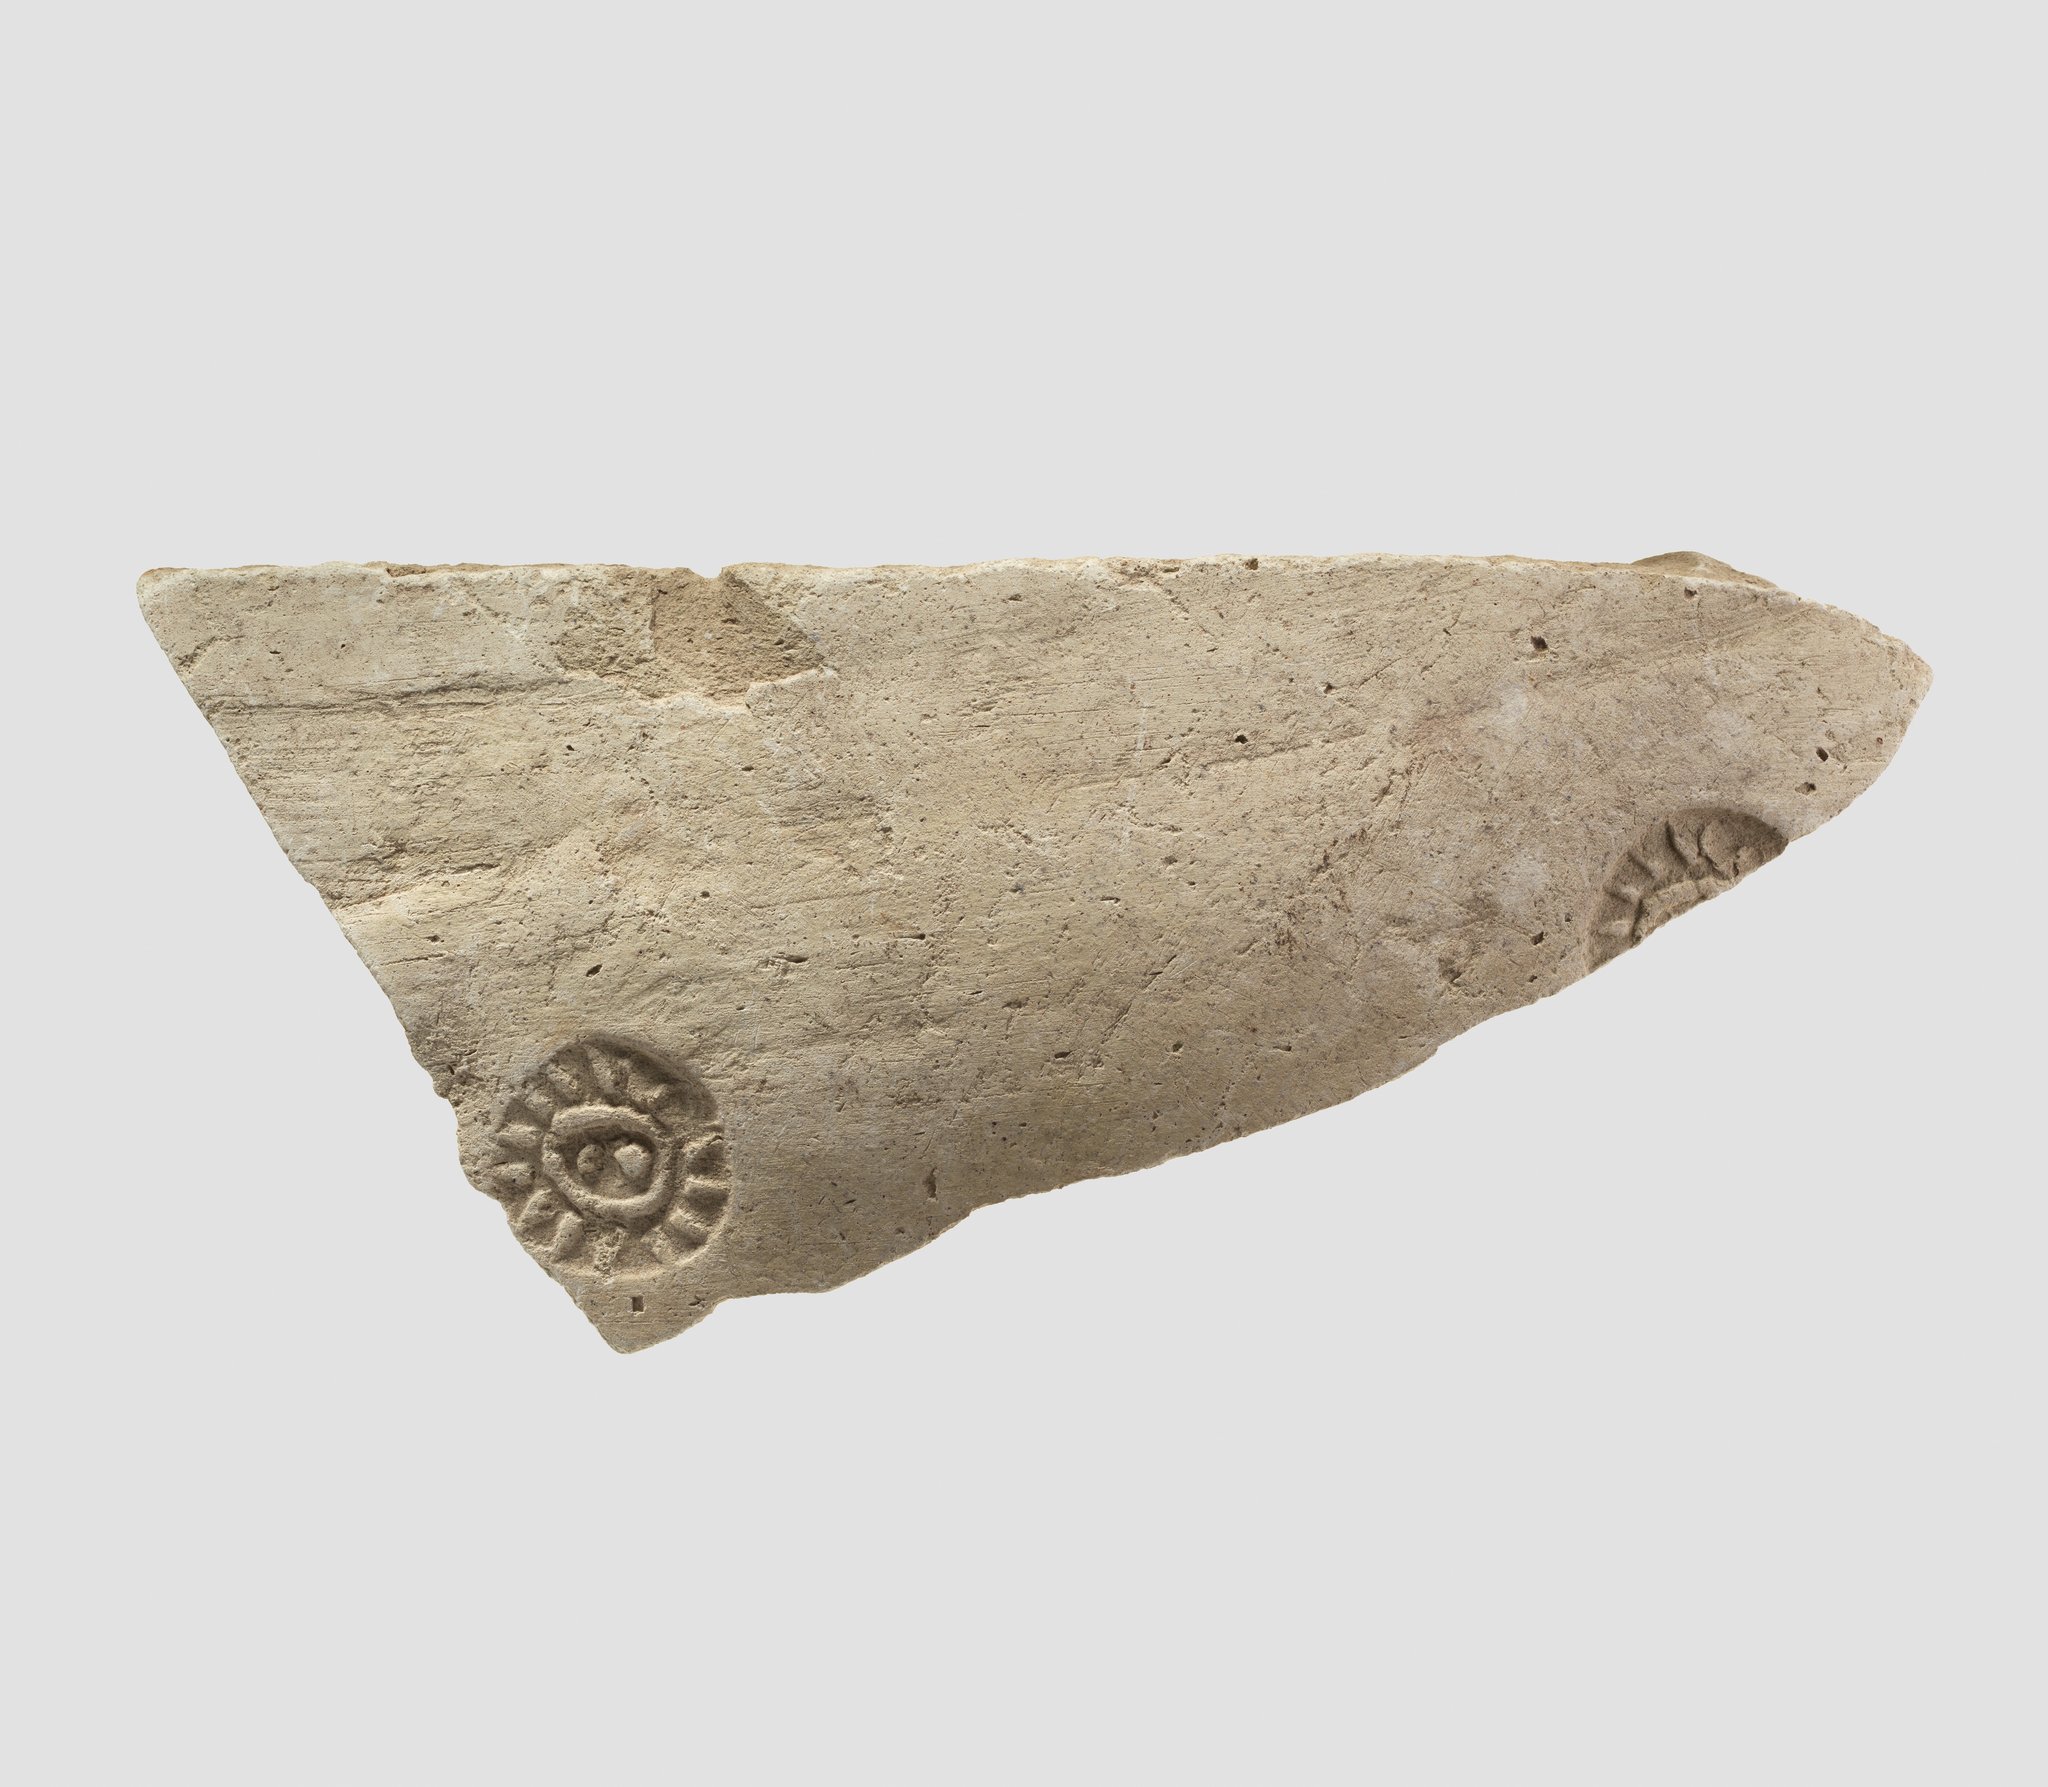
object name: sherd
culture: sasanian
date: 201-700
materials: ceramic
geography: mesopotamia